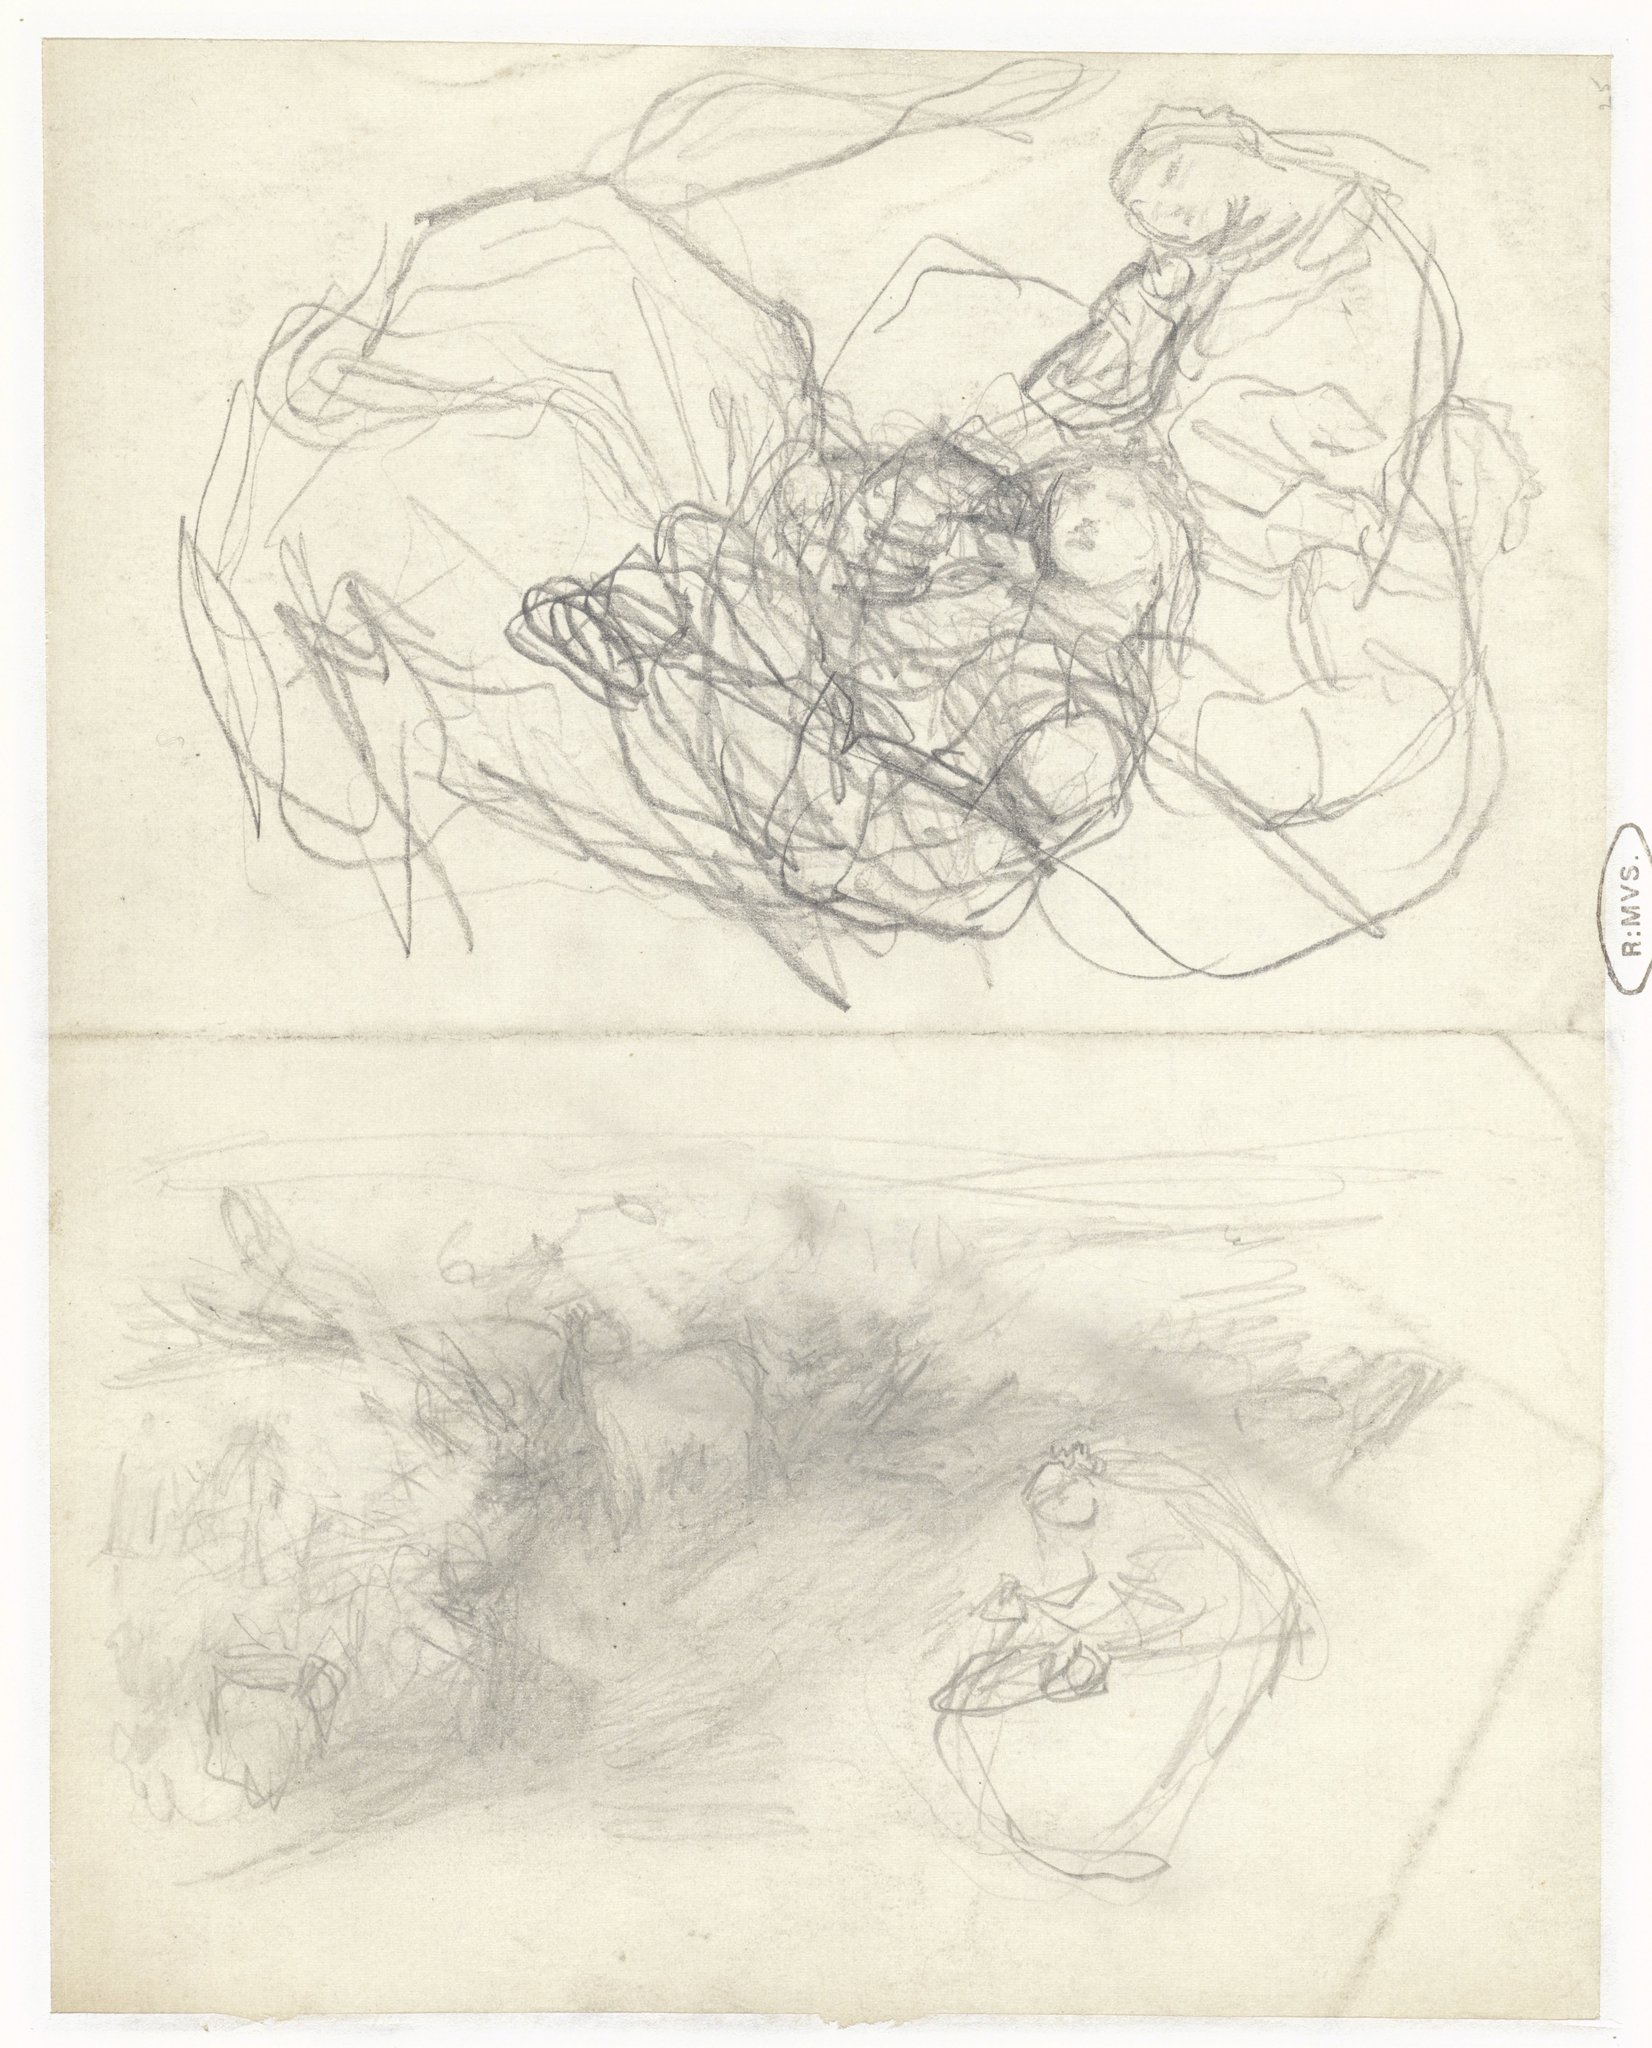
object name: drawing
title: Two Studies of a Woman Sitting in a Landscape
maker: matthijs maris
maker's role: draughtsman, painter, print maker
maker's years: 1839-1917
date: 1874-1875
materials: paper, pencil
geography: paris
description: In Paris Maris did not make fully worked-up studies, instead he sketched figures and tried out compositions, as can be seen here. In the top part of this sheet a girl tending goats can be discerned twice amidst the jumble of lines. In the bottom half Maris drew a composition sketch for the painting Girl with Goats, also on view in this gallery.